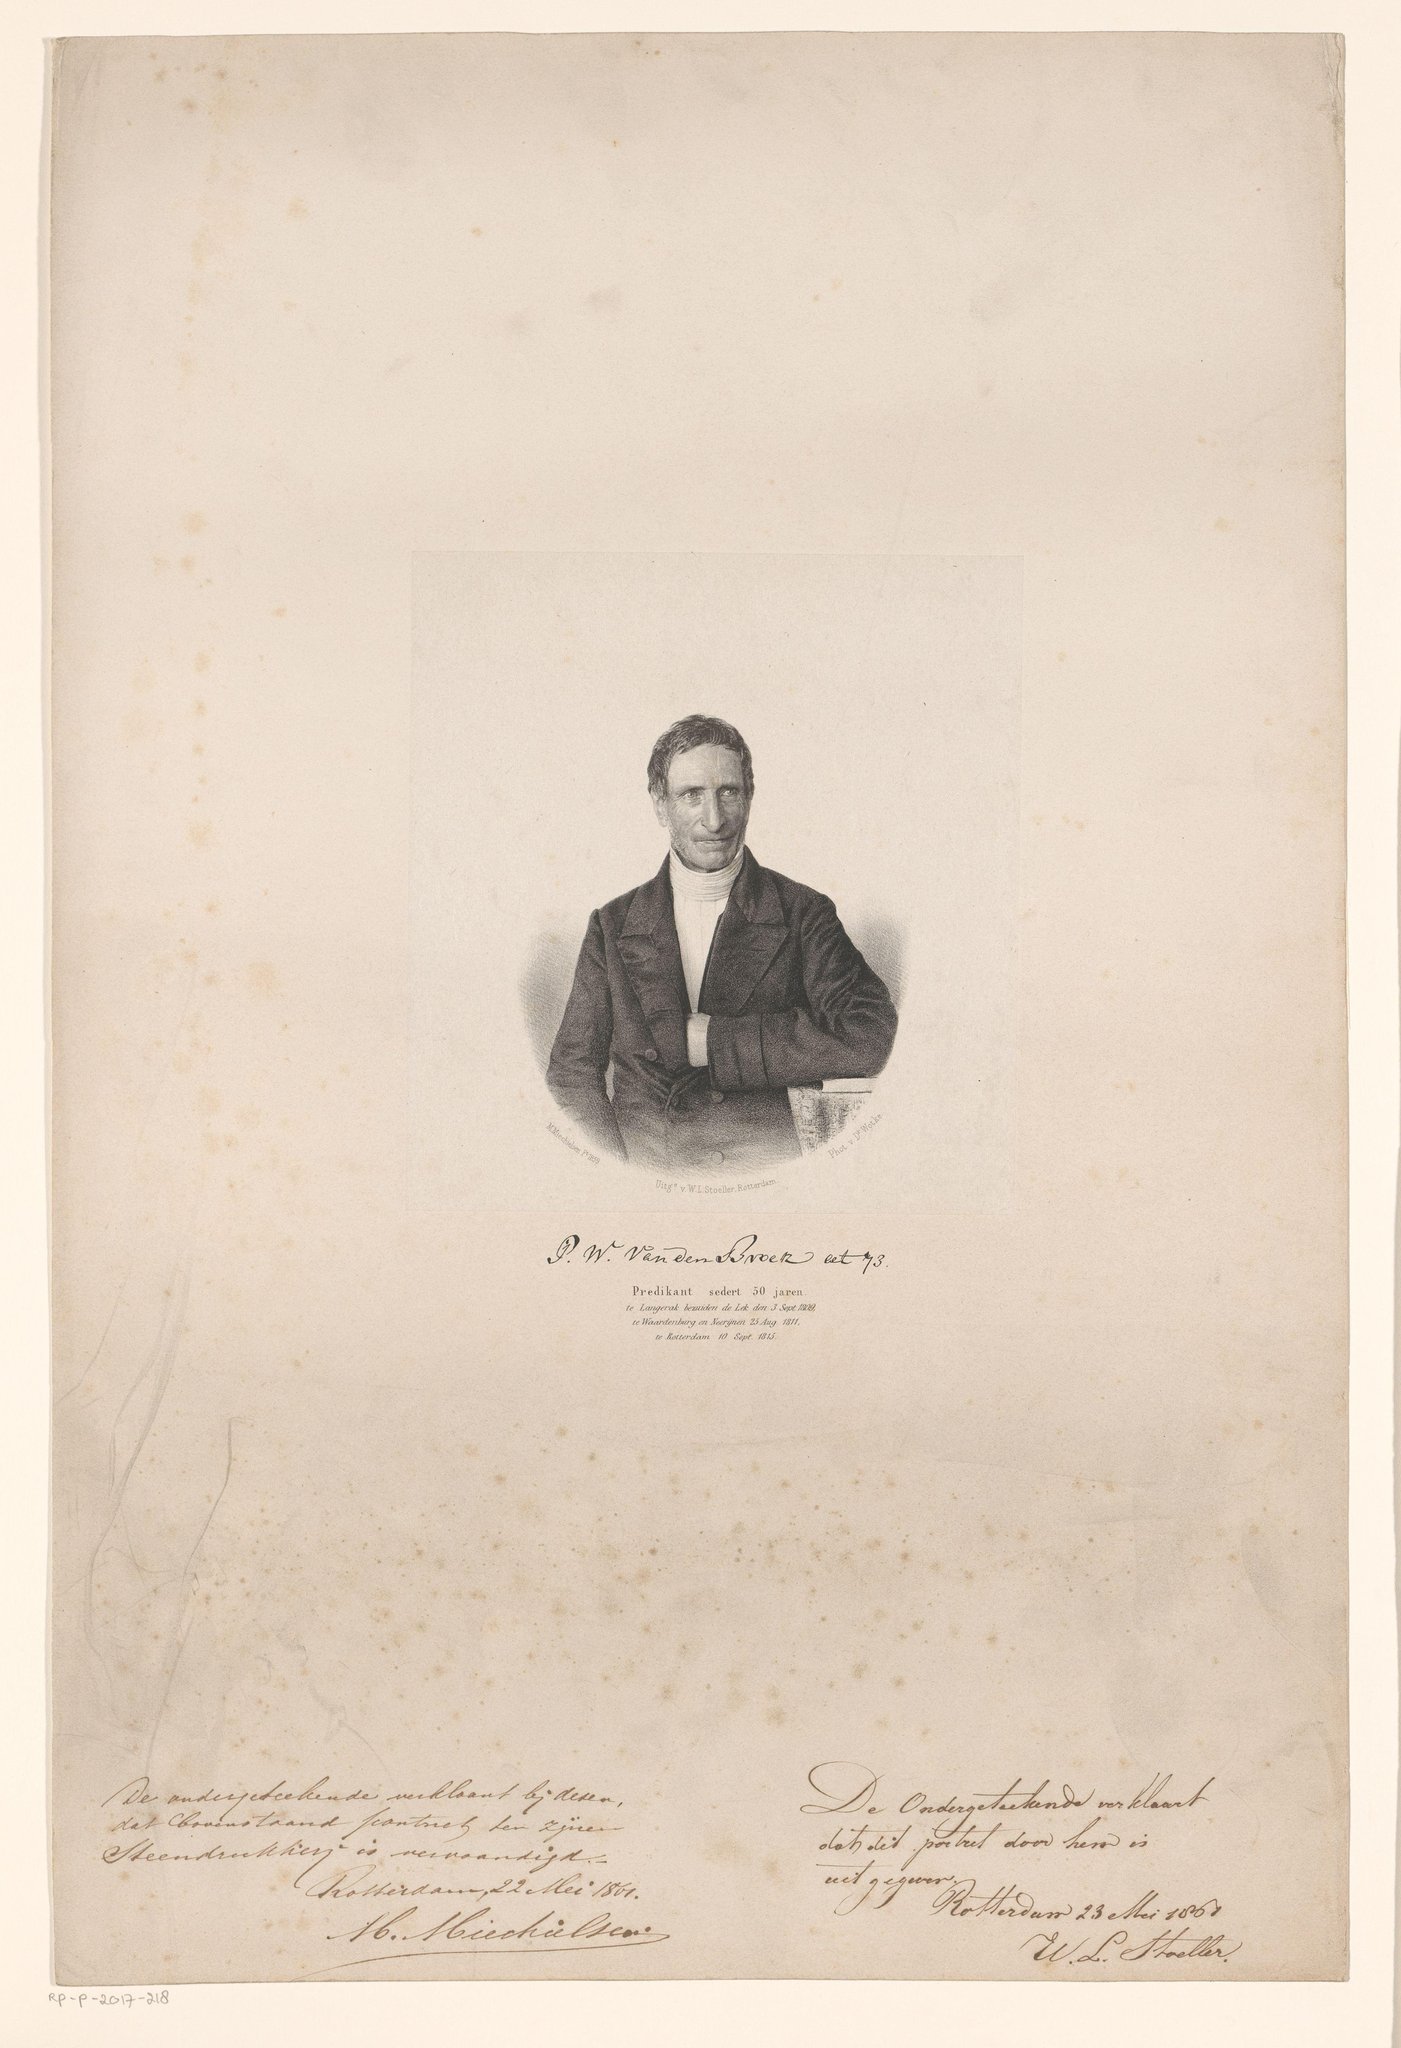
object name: print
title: Portret van P. W. van den Broer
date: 1861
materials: paper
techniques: lithograph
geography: rotterdam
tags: historical persons (+ (full) bust portrait)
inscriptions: : ‘De ondergeteekende verklaart / dat dit portret door hen is / uitgegeven. / Rotterdam 23 mei 1861 / W.L. Stoeller’, : ‘De ondergeteekende verklaart bij deze / dat bovenstaand portret ter zijner / steendrukkerij is vervaardigd. / Rotterdam 22 mei 1861’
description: Onder het portret de signatuur van de geportretteerde.